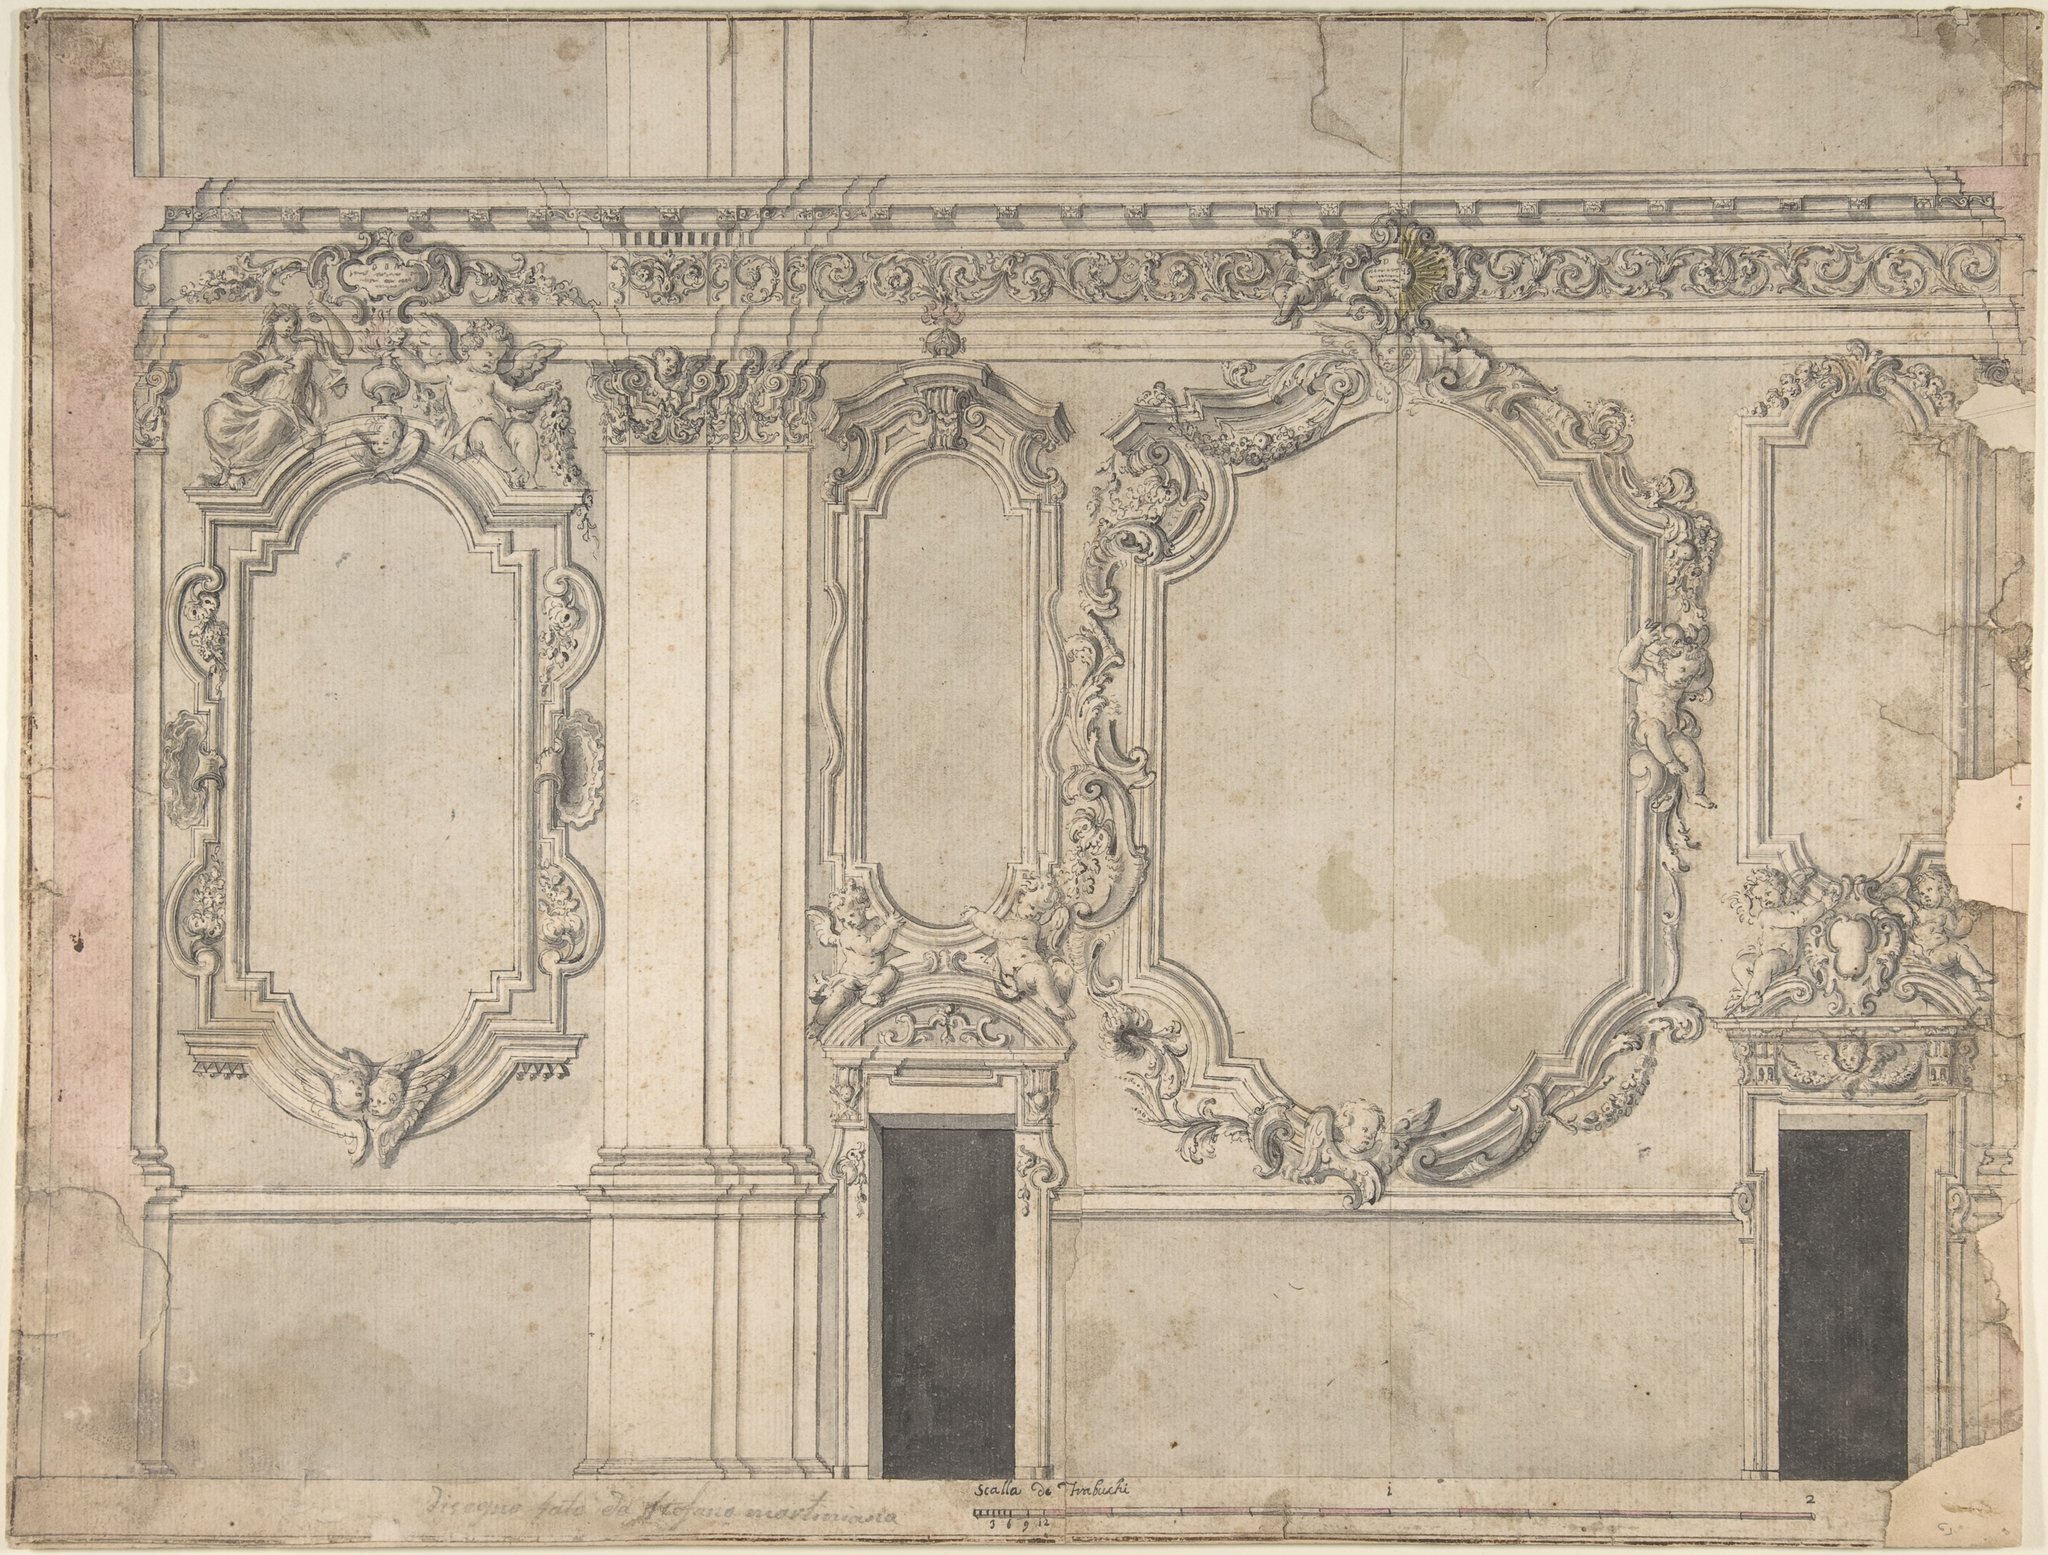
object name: drawing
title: Design for an Interior Wall Elevation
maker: anonymous, italian, piedmontese, 18th century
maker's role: artist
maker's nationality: italian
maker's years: 1700-1800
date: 1700-1780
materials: ink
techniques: brush, pen, wash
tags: architecture,interiors